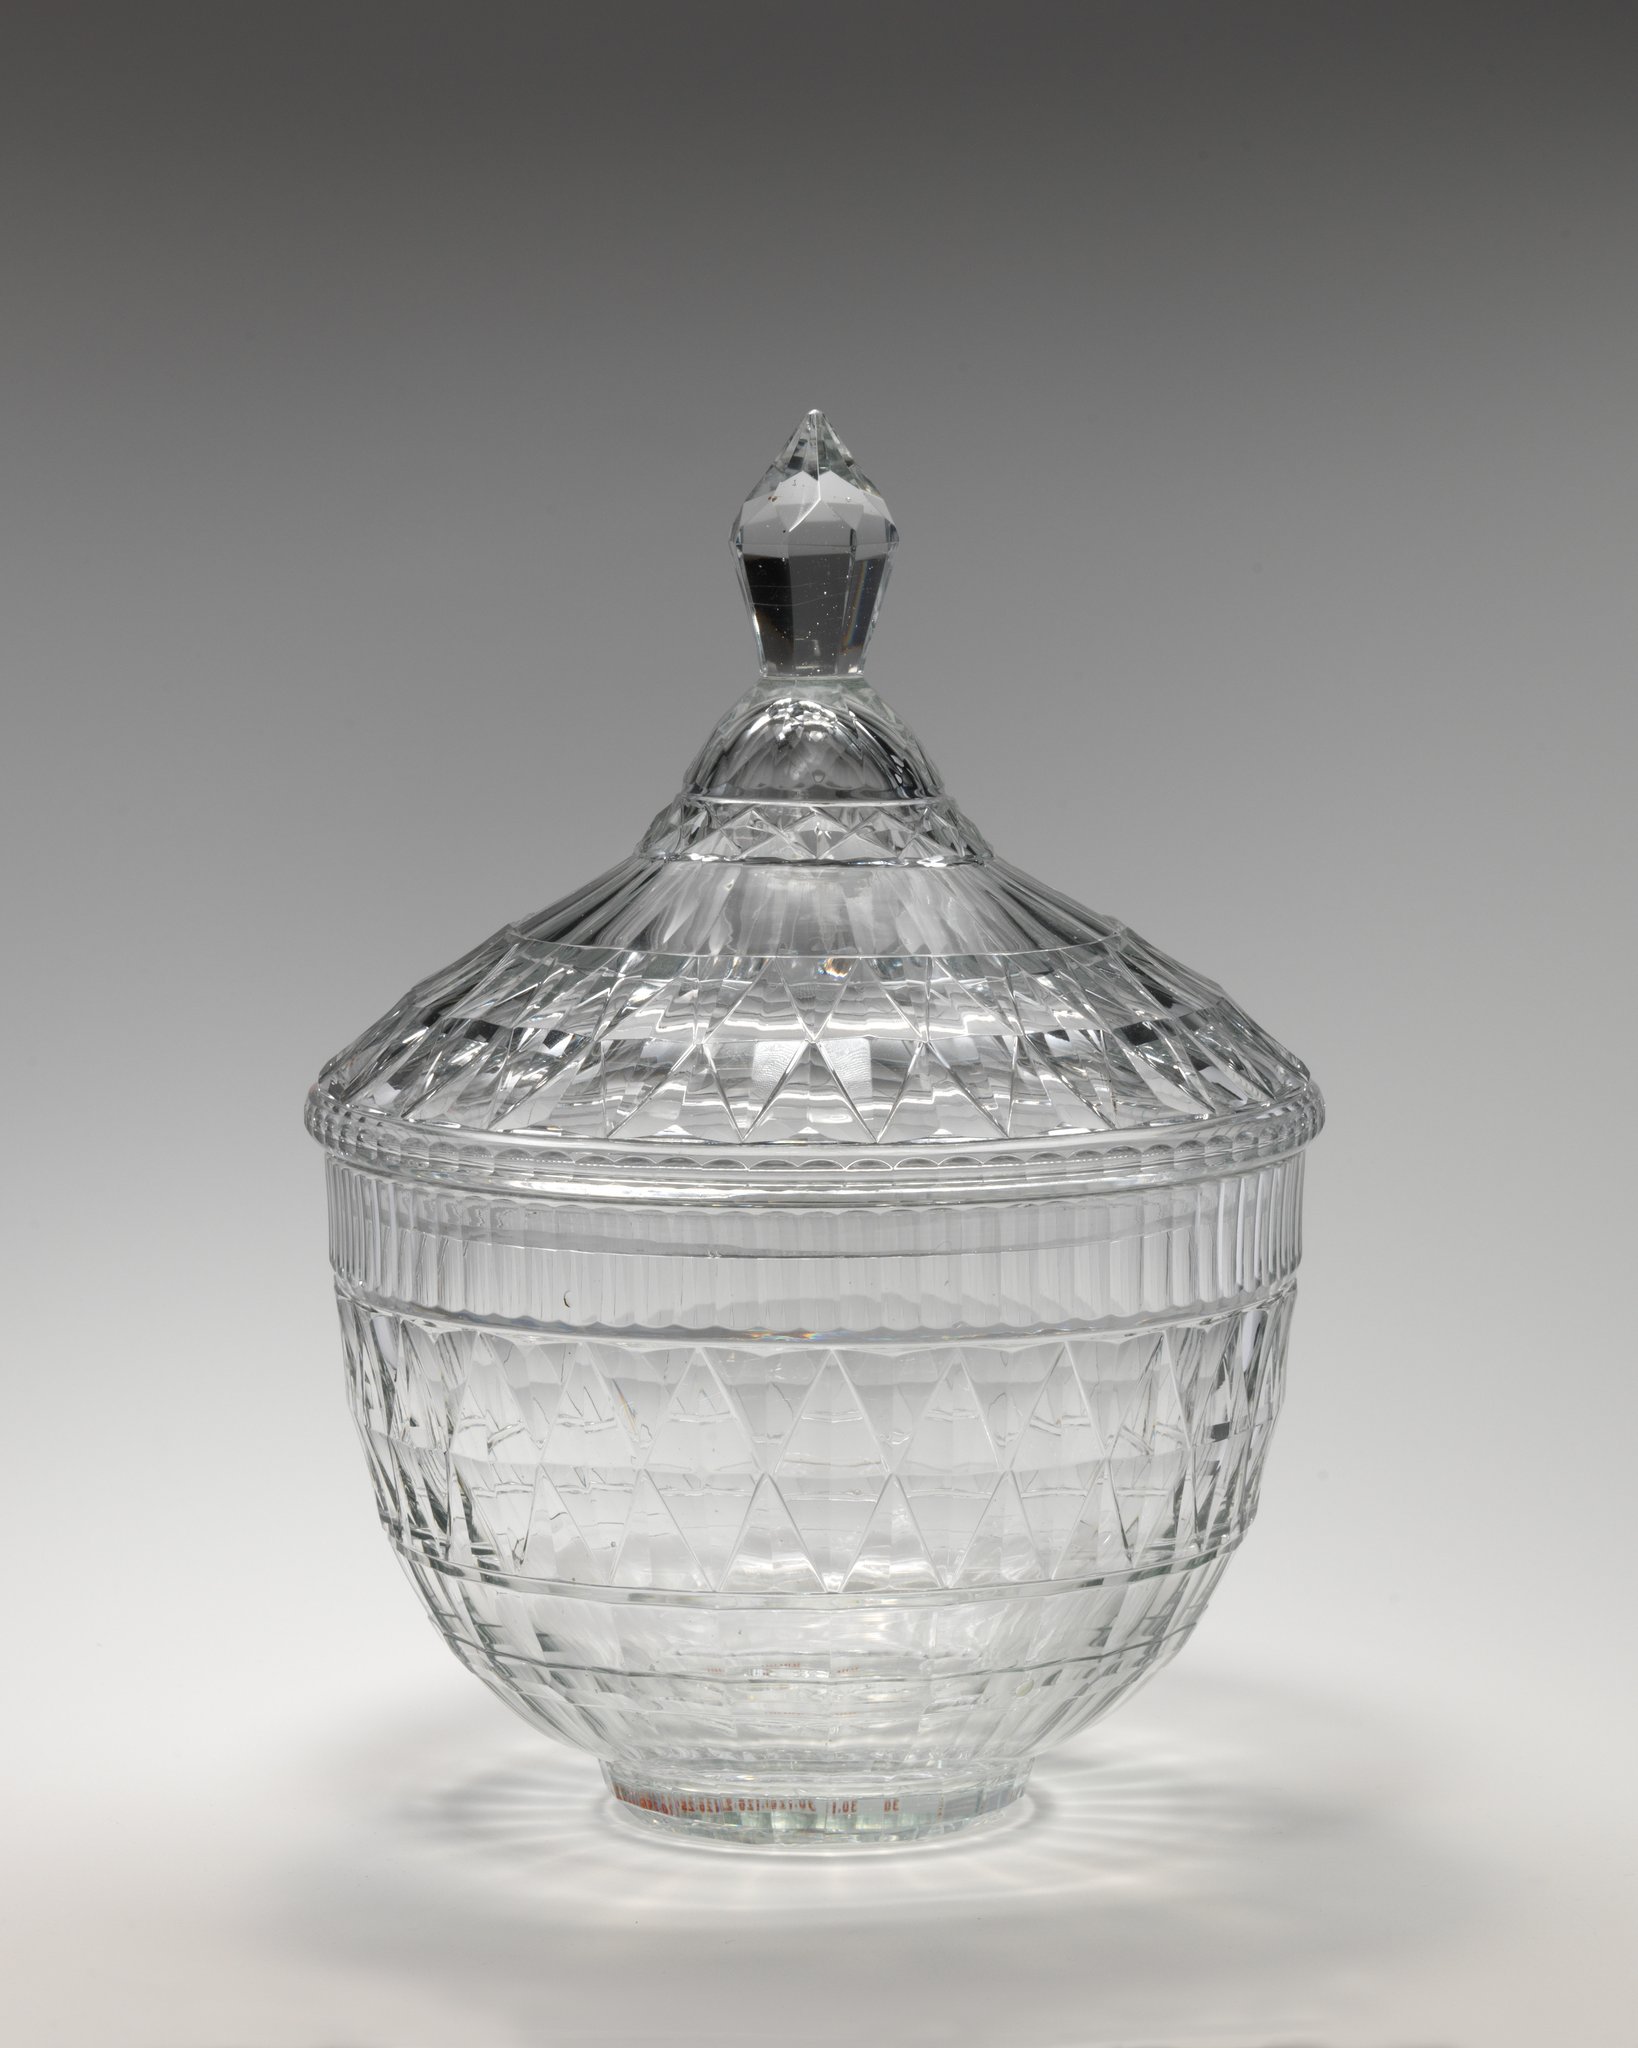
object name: bowl with cover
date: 1767-1833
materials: glass